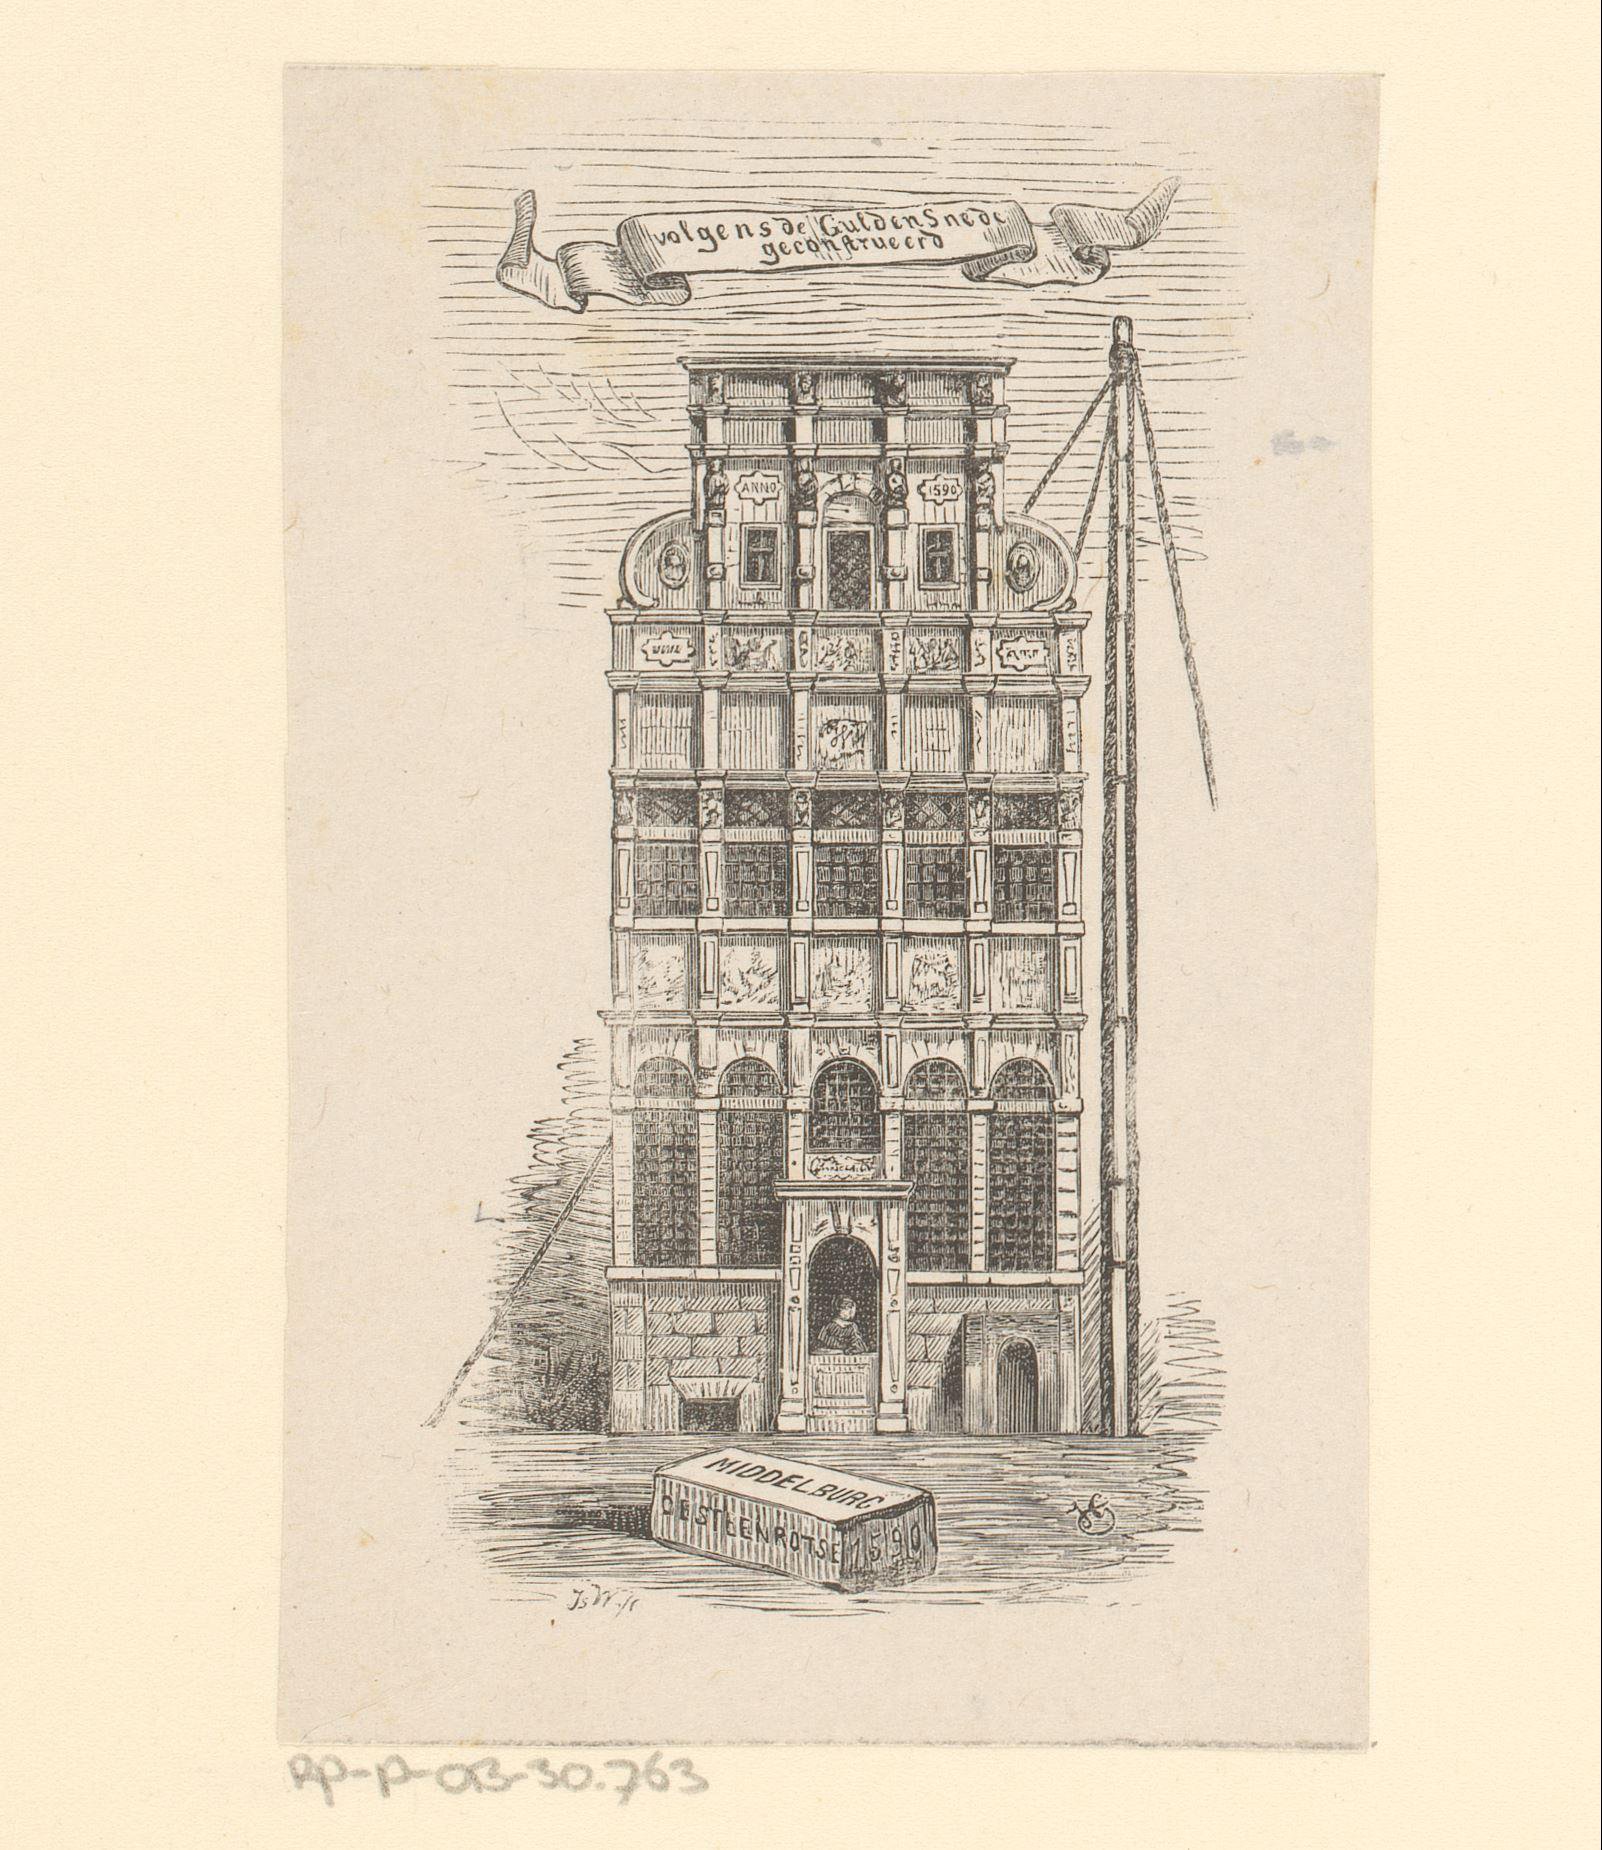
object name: print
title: Gevel van het pand 'In de steenrotse' aan de Dwarskaai te Middelburg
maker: isaac weissenbruch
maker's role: print maker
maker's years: 1826-1912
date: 1836-1912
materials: paper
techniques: engraving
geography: netherlands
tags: huis in de steenrotse